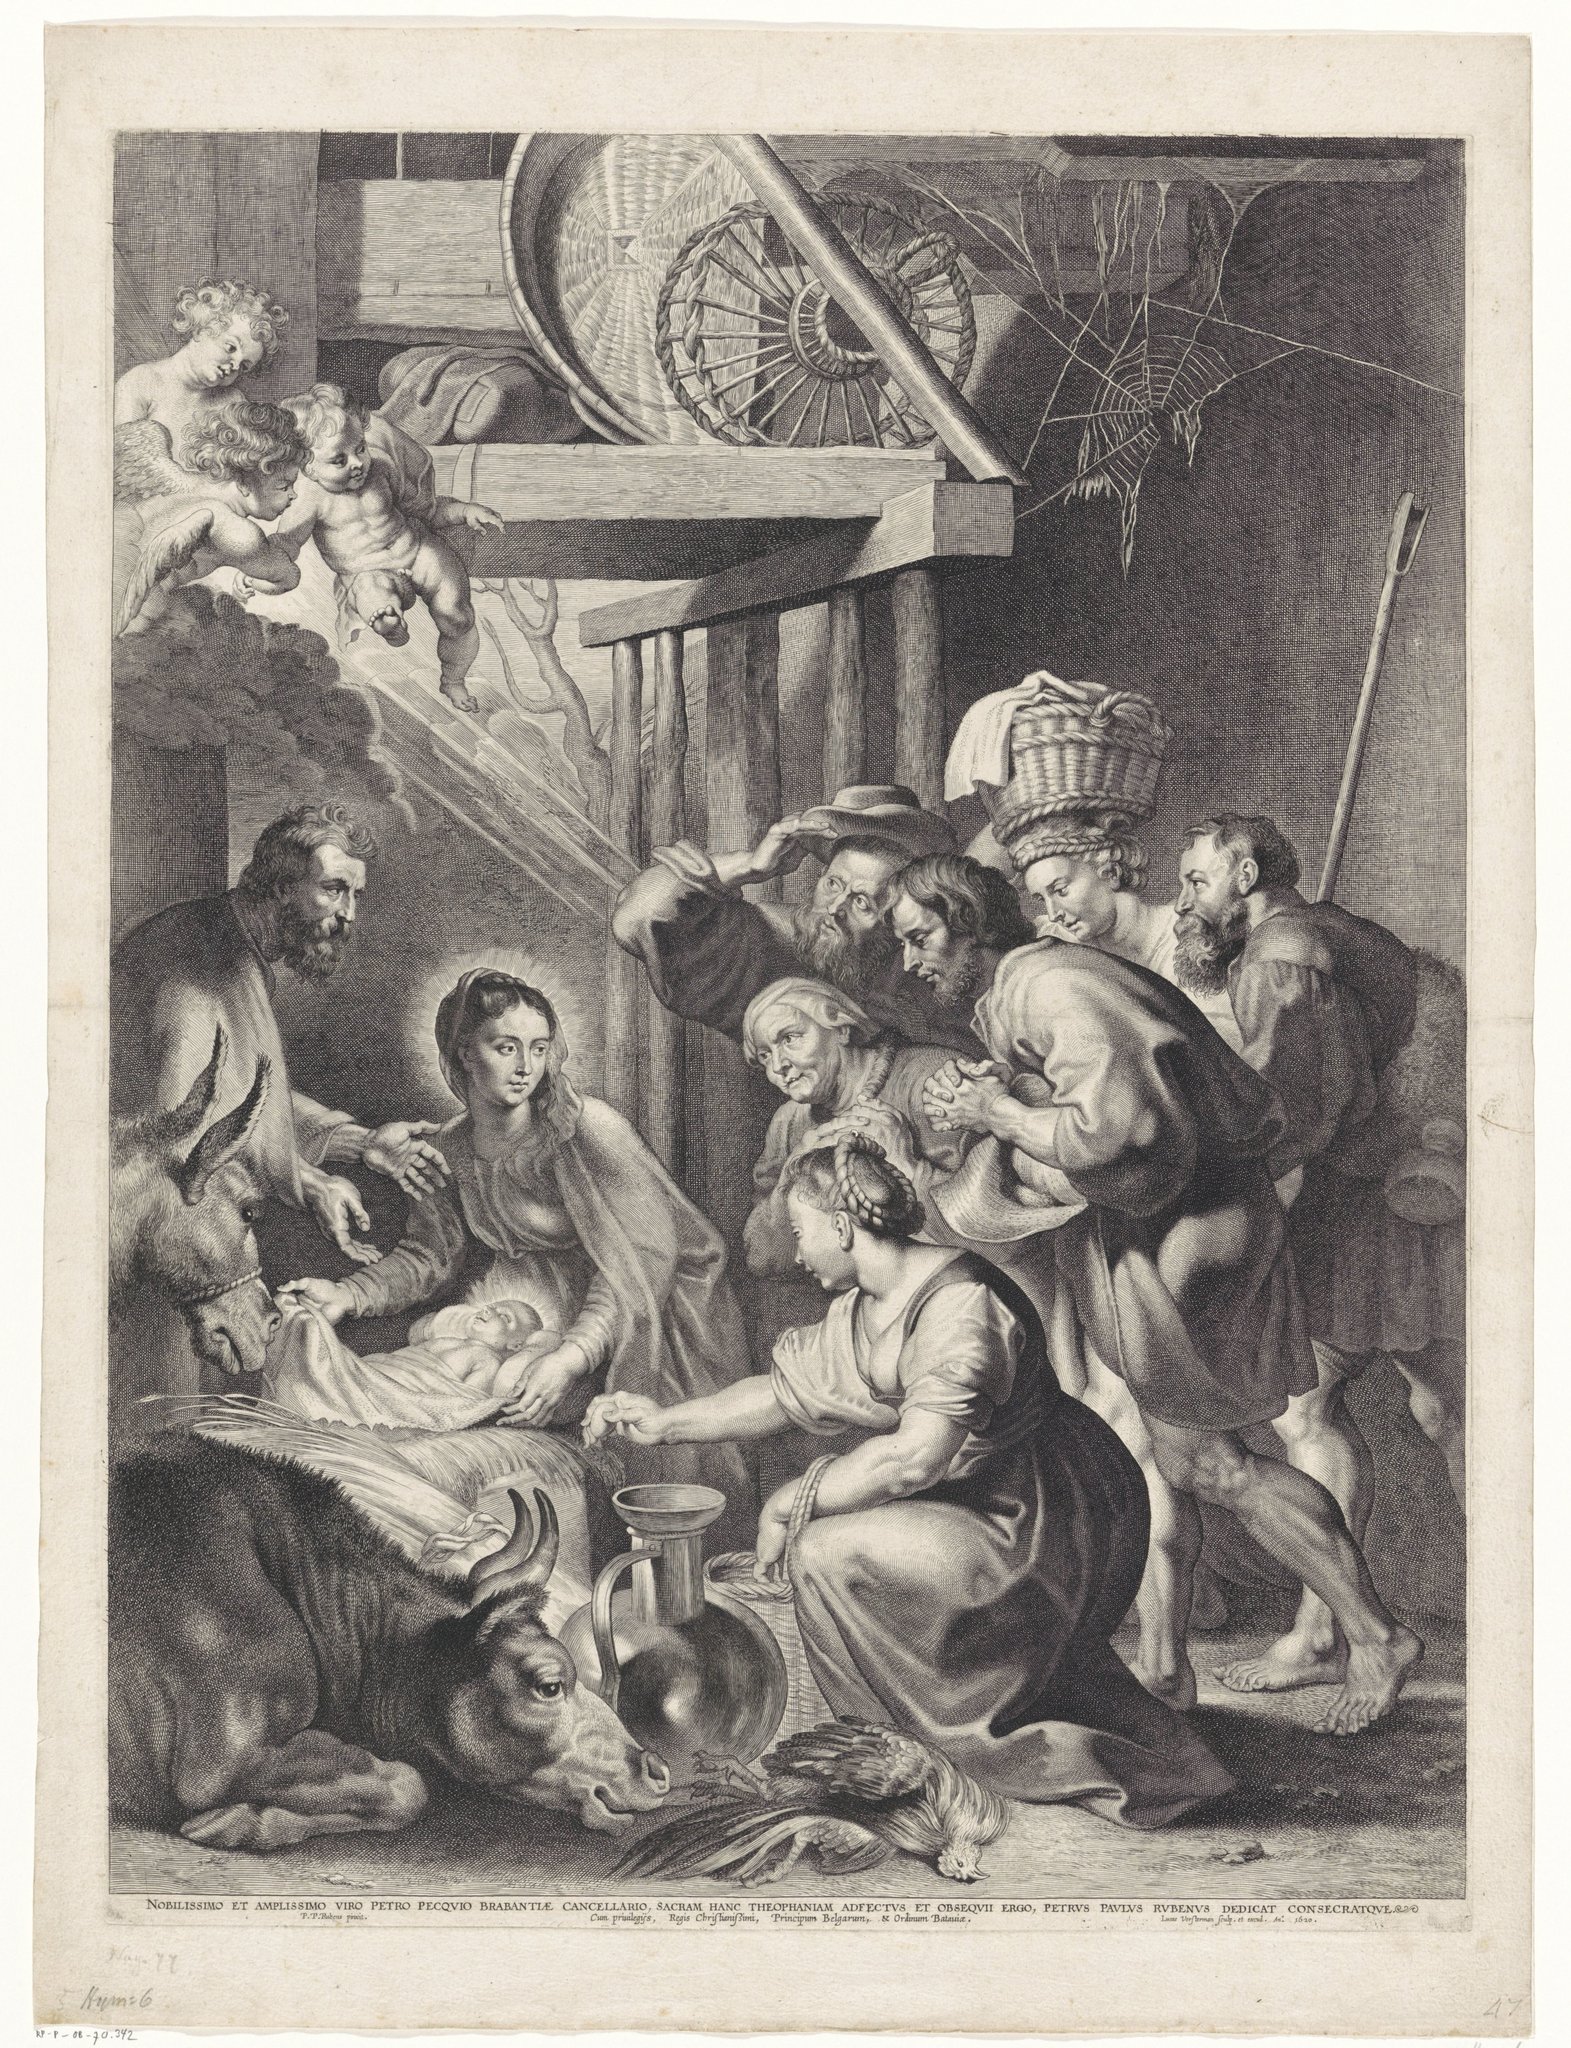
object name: print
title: Aanbidding der herders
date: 1620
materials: paper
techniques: engraving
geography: antwerp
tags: adoration of the christ-child by the shepherds; mary and joseph present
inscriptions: collector's mark: Lugt 2228